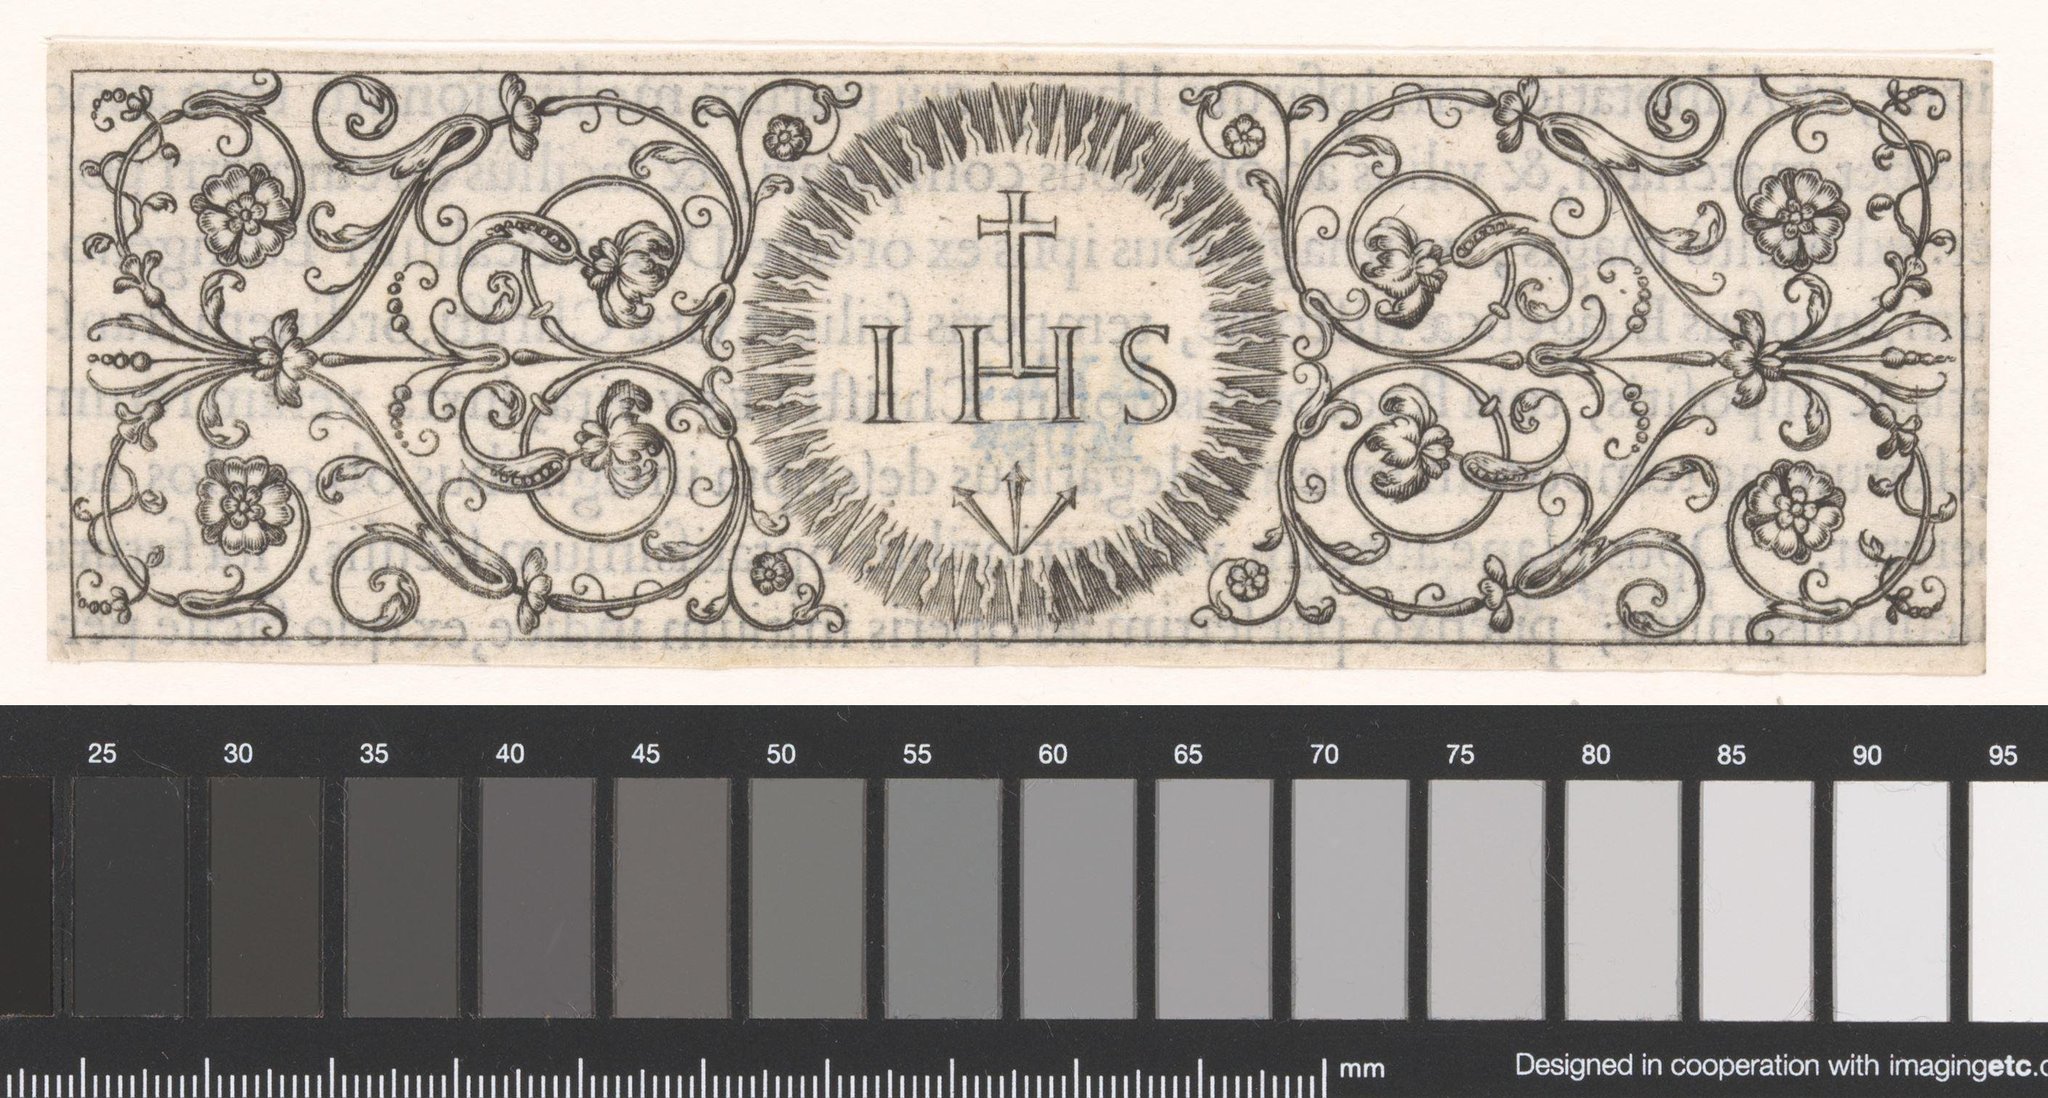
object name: print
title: Ornament met monogram IHS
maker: Anonymous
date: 1600-1800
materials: paper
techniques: engraving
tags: ornaments ~ art, ihs ('iesus hominum salvator') ~ symbol of christ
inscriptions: collector's mark: Lugt 2165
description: Arabesken met in het midden een zon met monogram IHS.